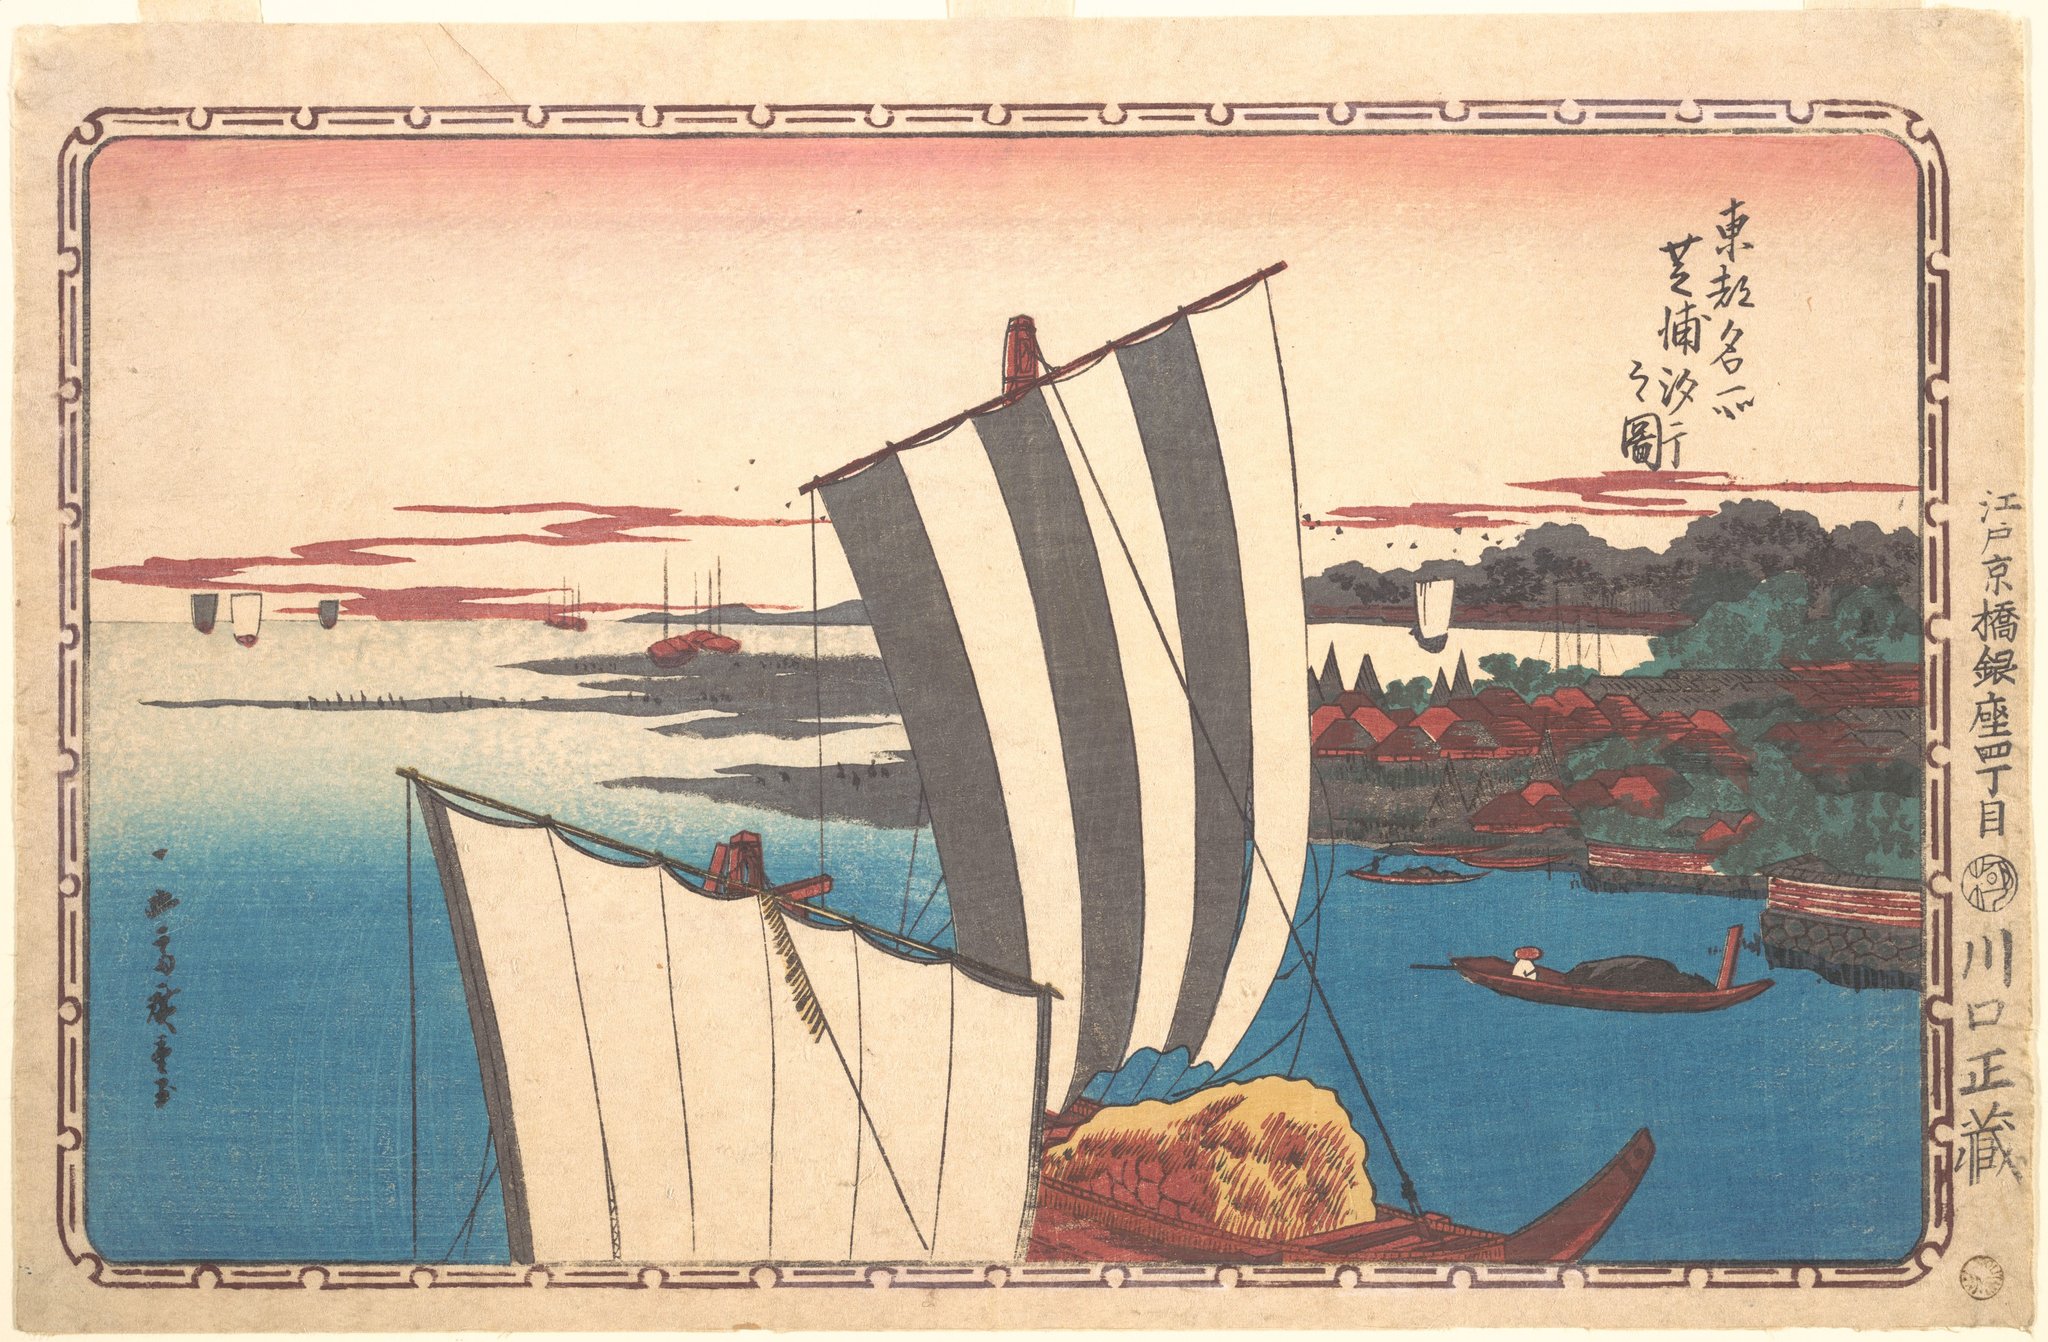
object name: print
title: Shell Gathering at Shibaura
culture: japanese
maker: utagawa hiroshige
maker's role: artist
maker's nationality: japanese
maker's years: 1797-1858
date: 1797-1858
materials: ink, paper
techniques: woodblock print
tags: boats